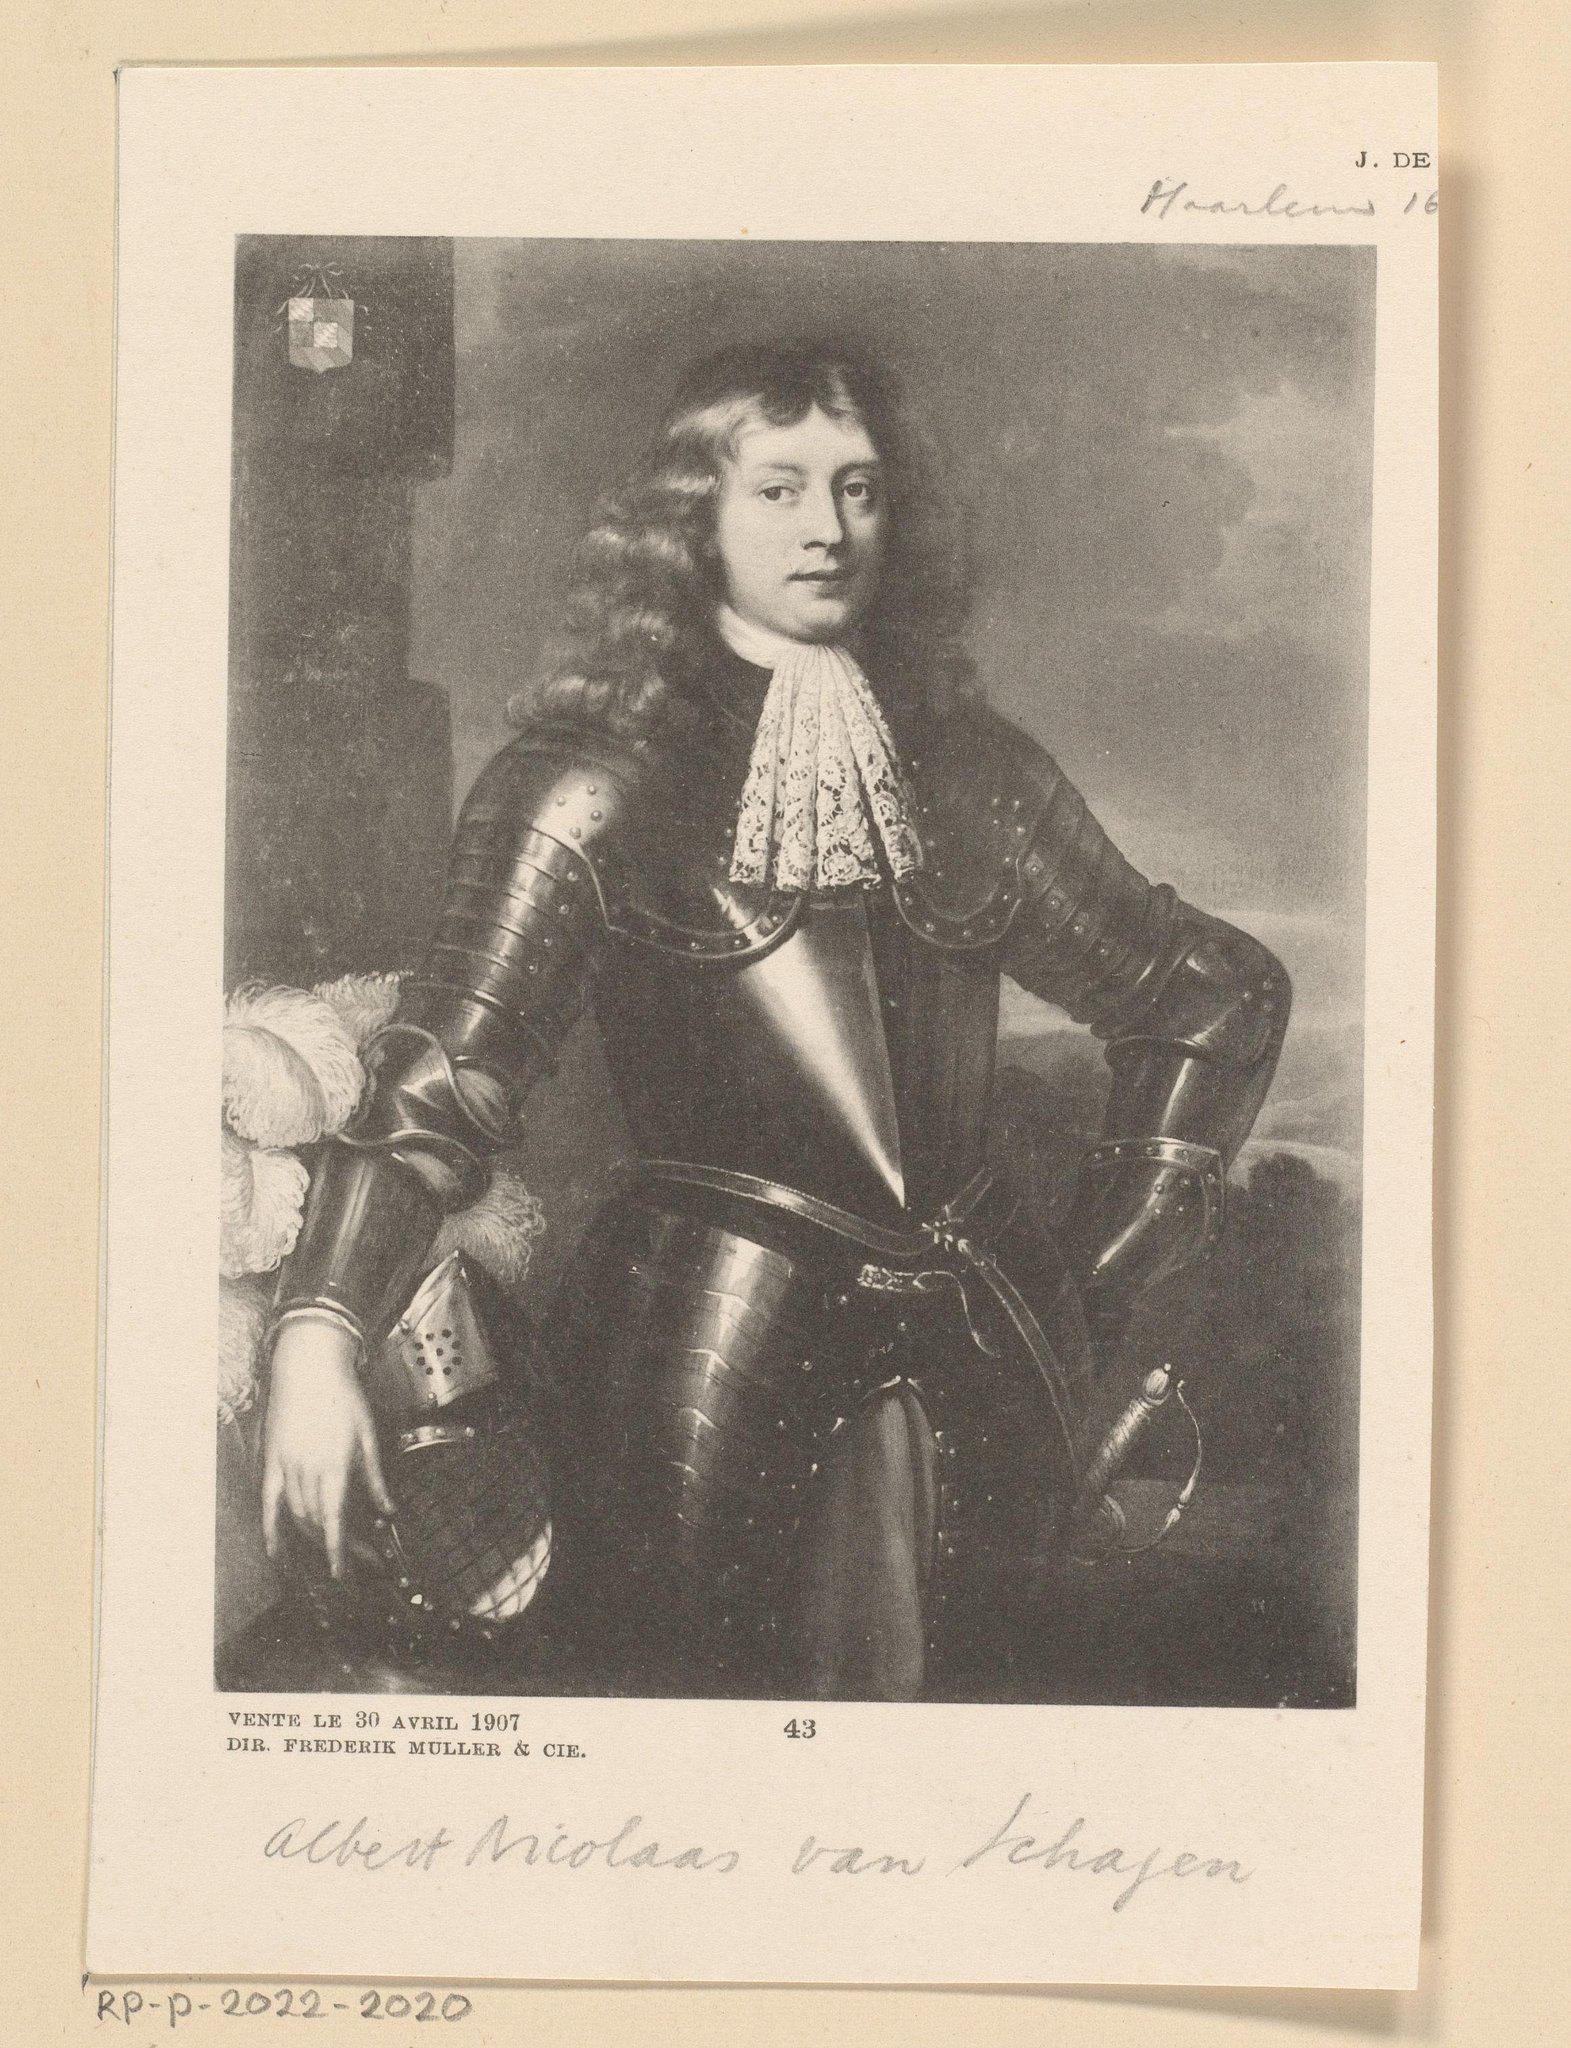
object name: photomechanical print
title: Portret van een man uit de familie Van Beyeren van Schagen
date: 1907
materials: paper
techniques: photograph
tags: armour, armorial bearing, heraldry, historical persons not known by name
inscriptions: inscription: ‘Haarlem 16 / Albert Nicolaas van Schagen’, name: ‘J. de Baen’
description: Fotomechanische afdruk uit een veilingcatalogus van Frederik Muller & Cie (Amsterdam), 1907-04-30, cat. nr. 43.